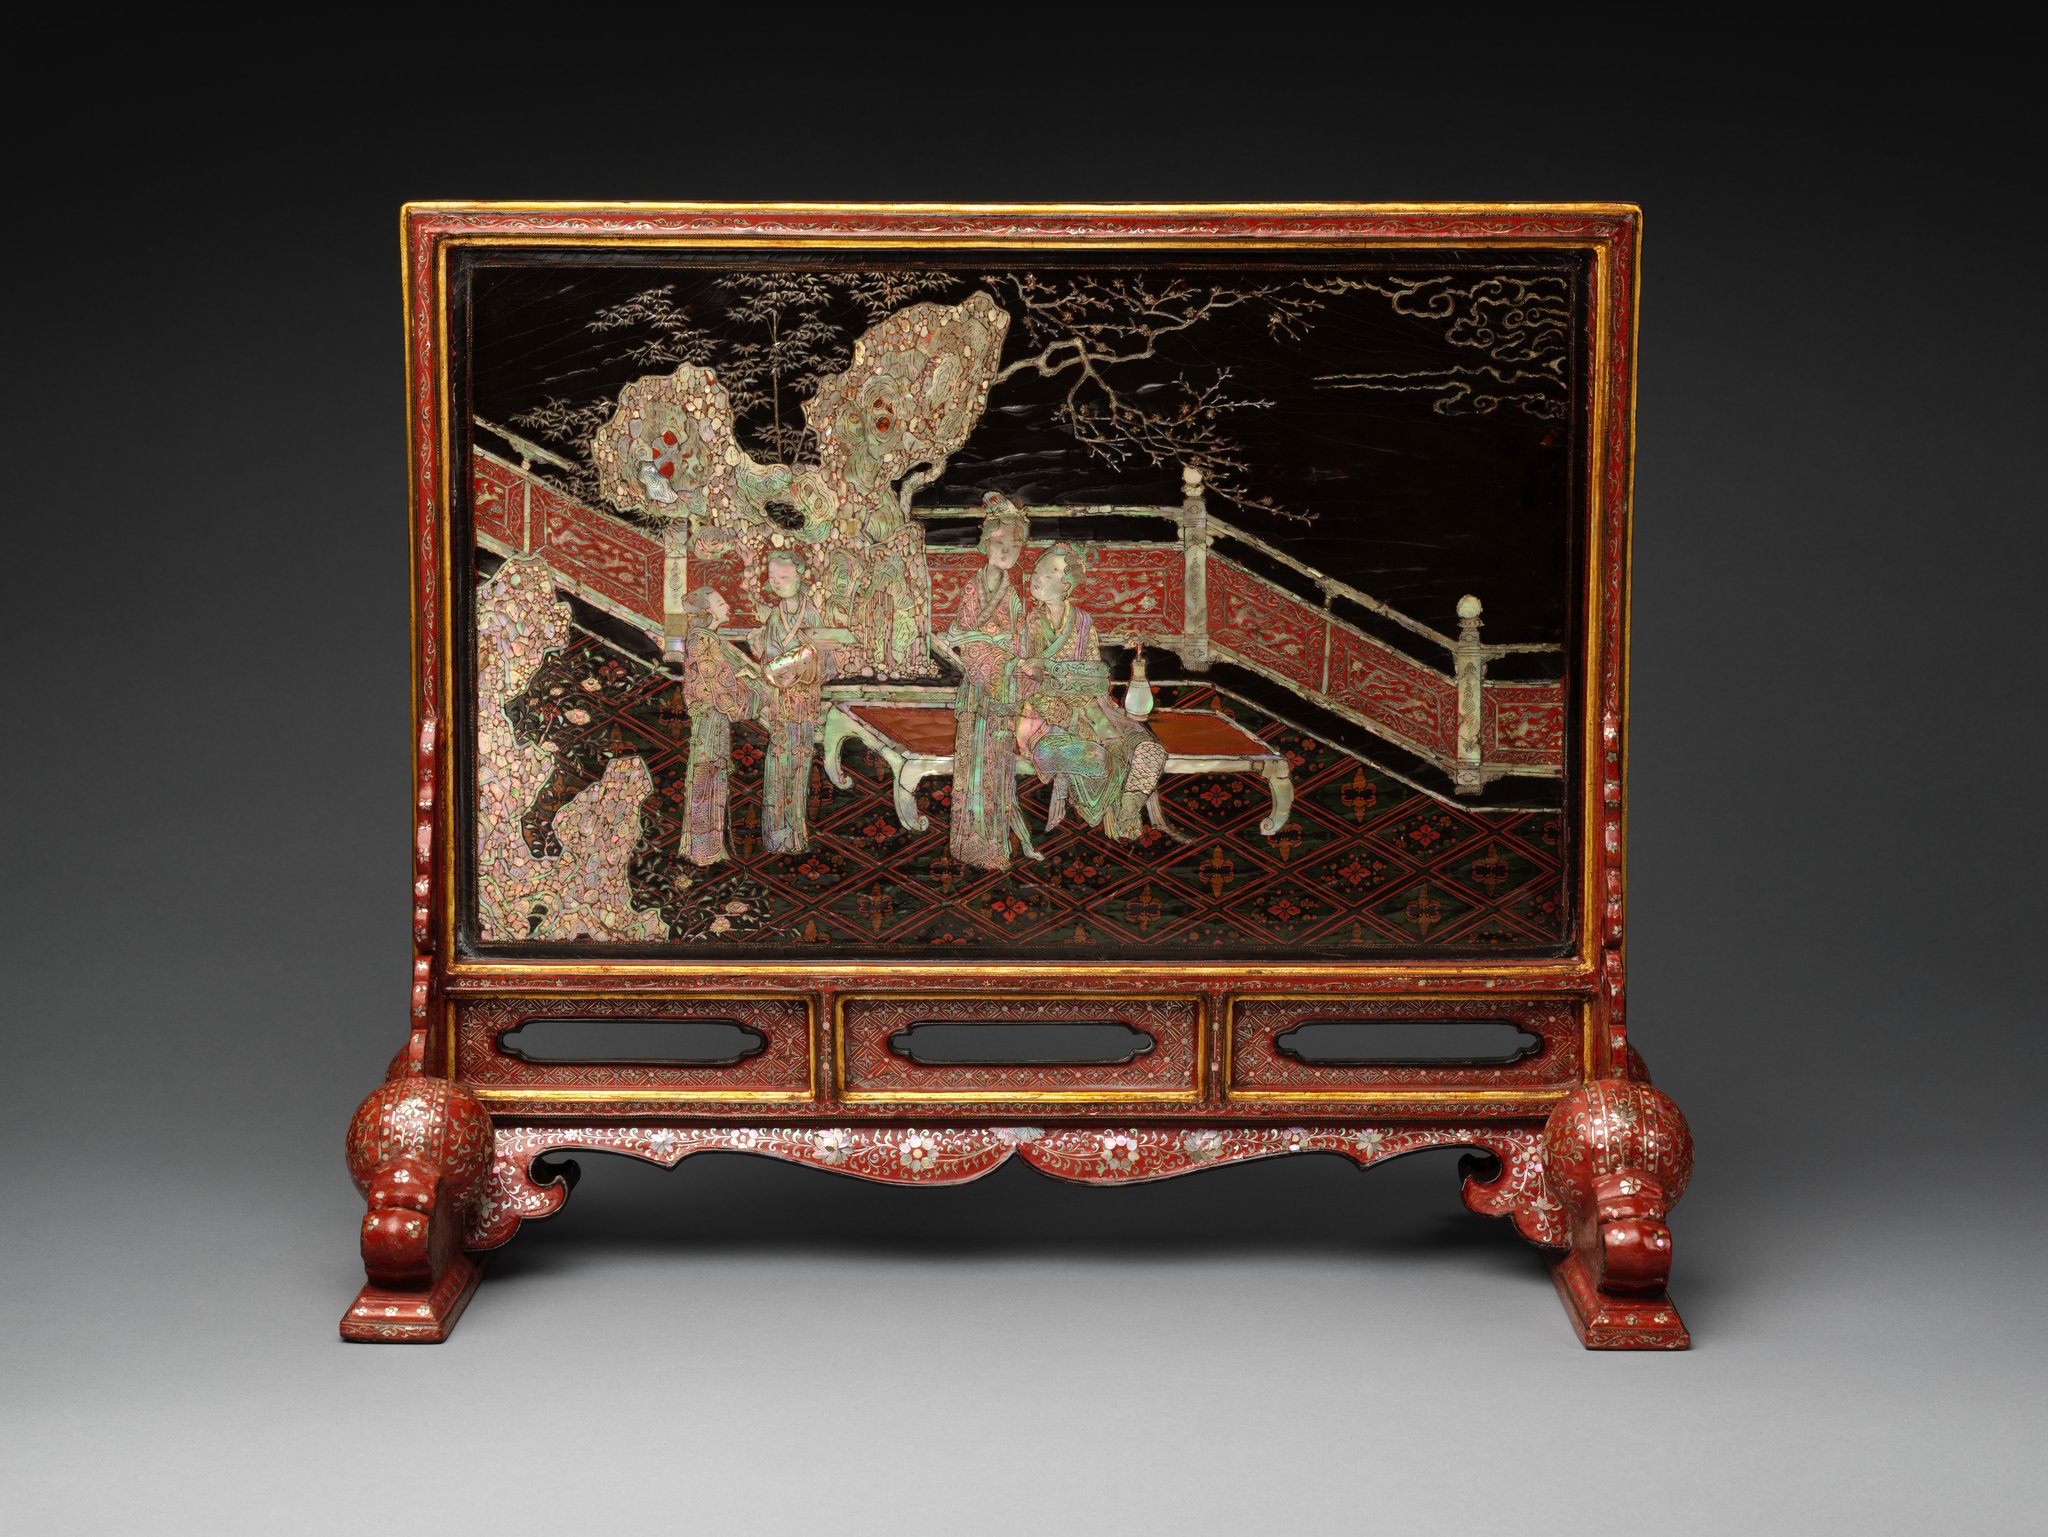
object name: table screen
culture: chinese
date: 1567-1633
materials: lacquer, mother of pearl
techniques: inlay